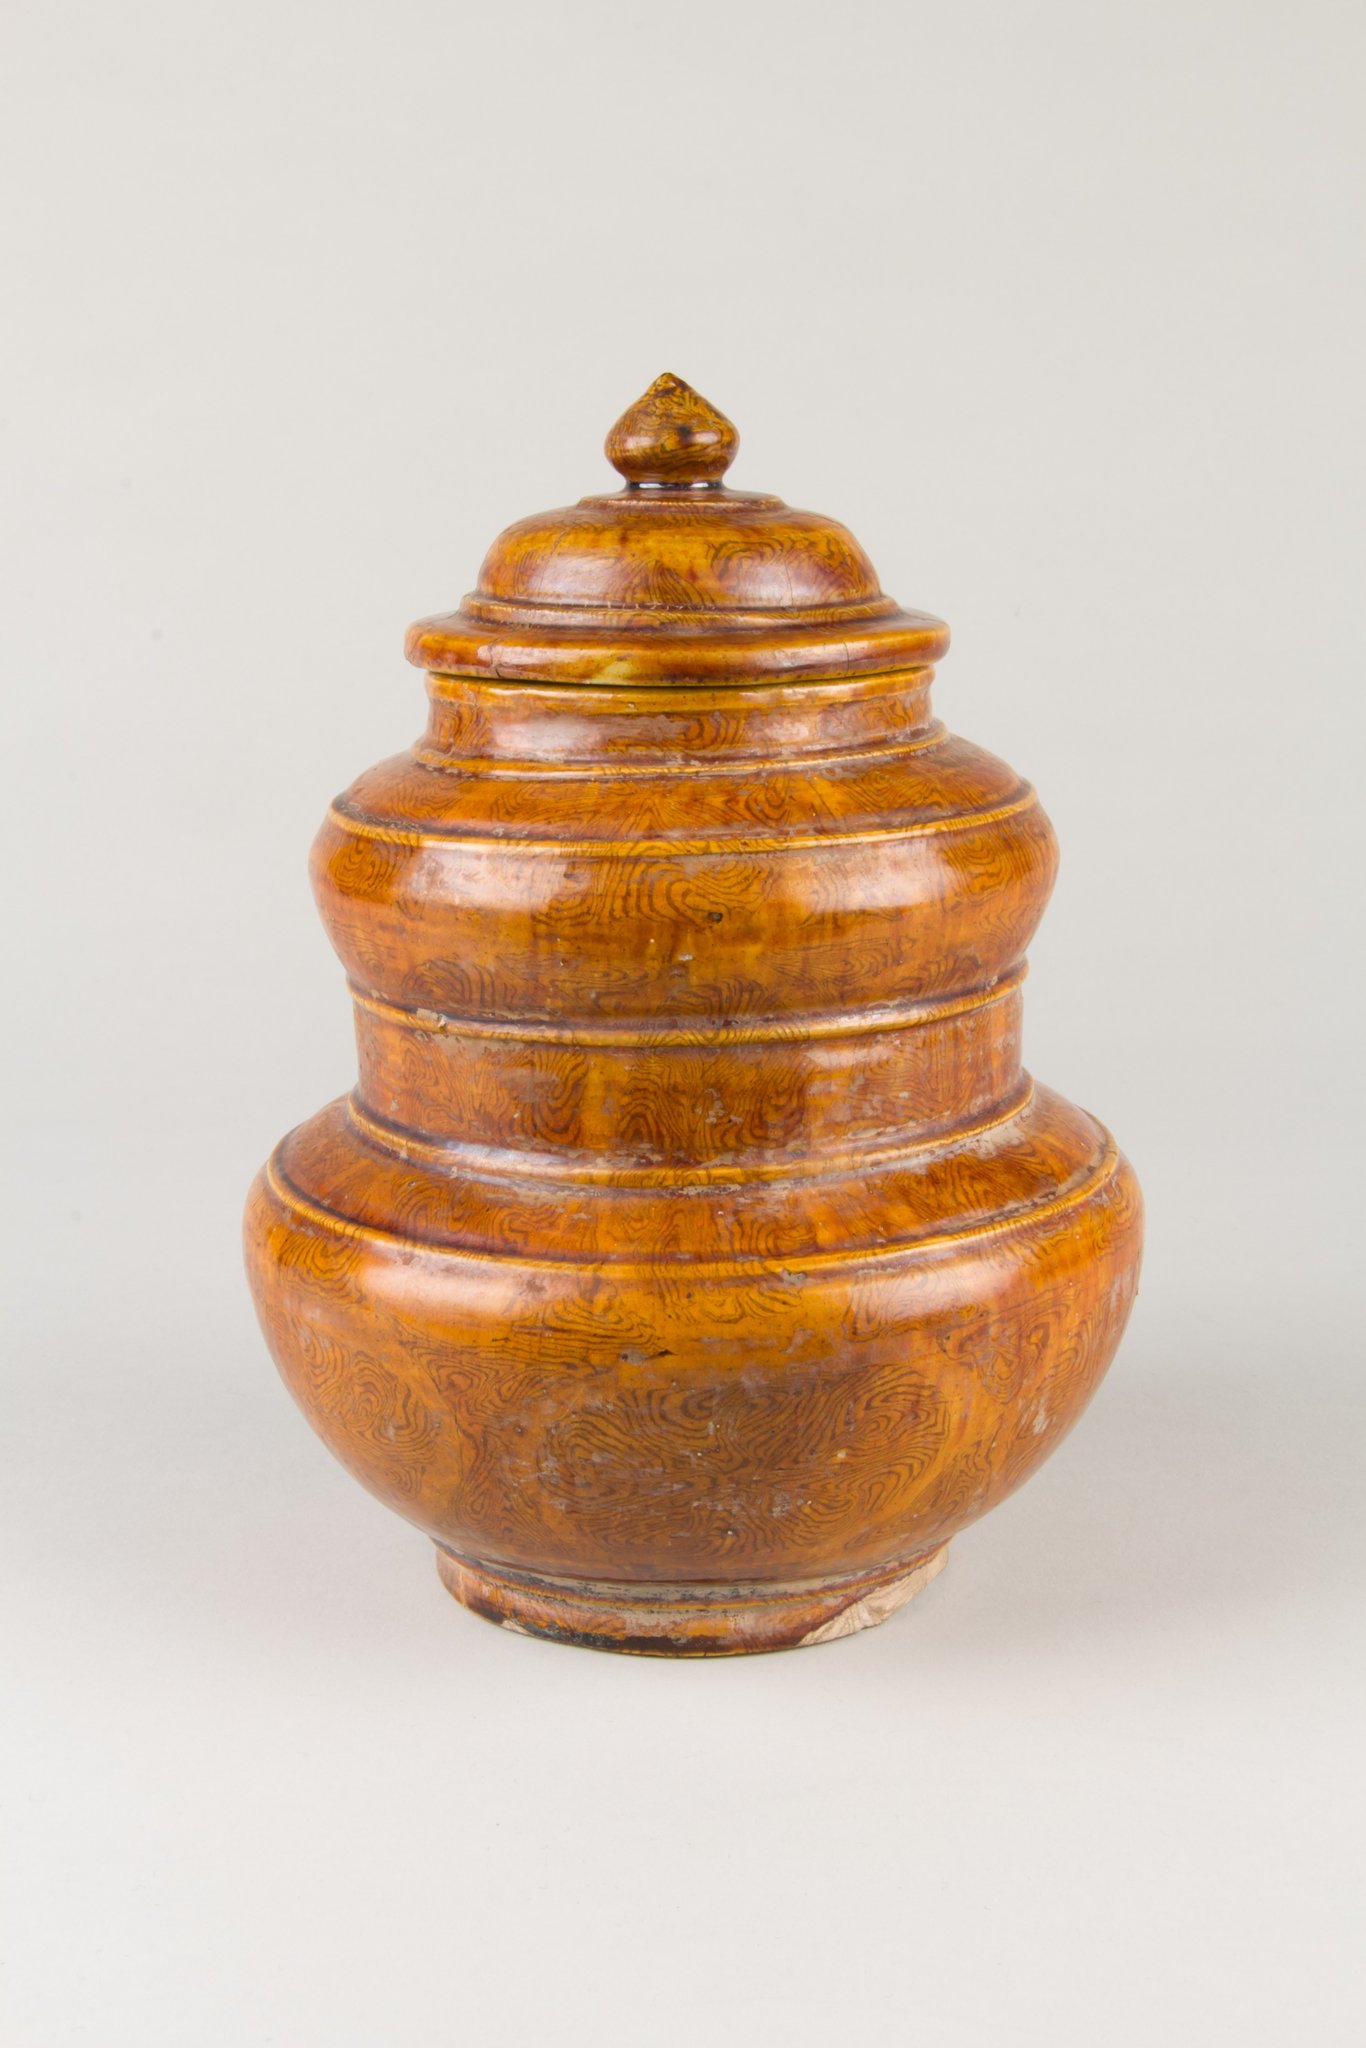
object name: covered jar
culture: chinese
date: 1901-2000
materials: glaze, pottery